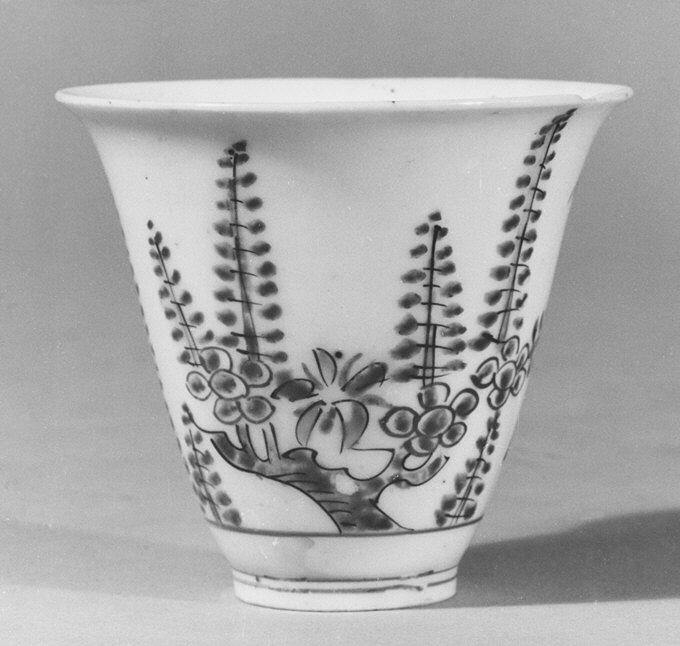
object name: cup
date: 1701-1800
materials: hard paste porcelain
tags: flowers,trees